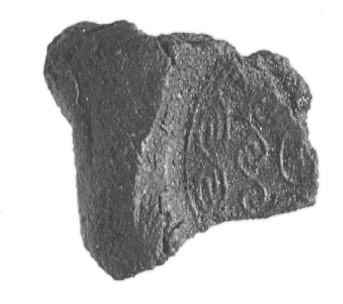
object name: sealing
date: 2030-1640 BCE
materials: clay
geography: egypt